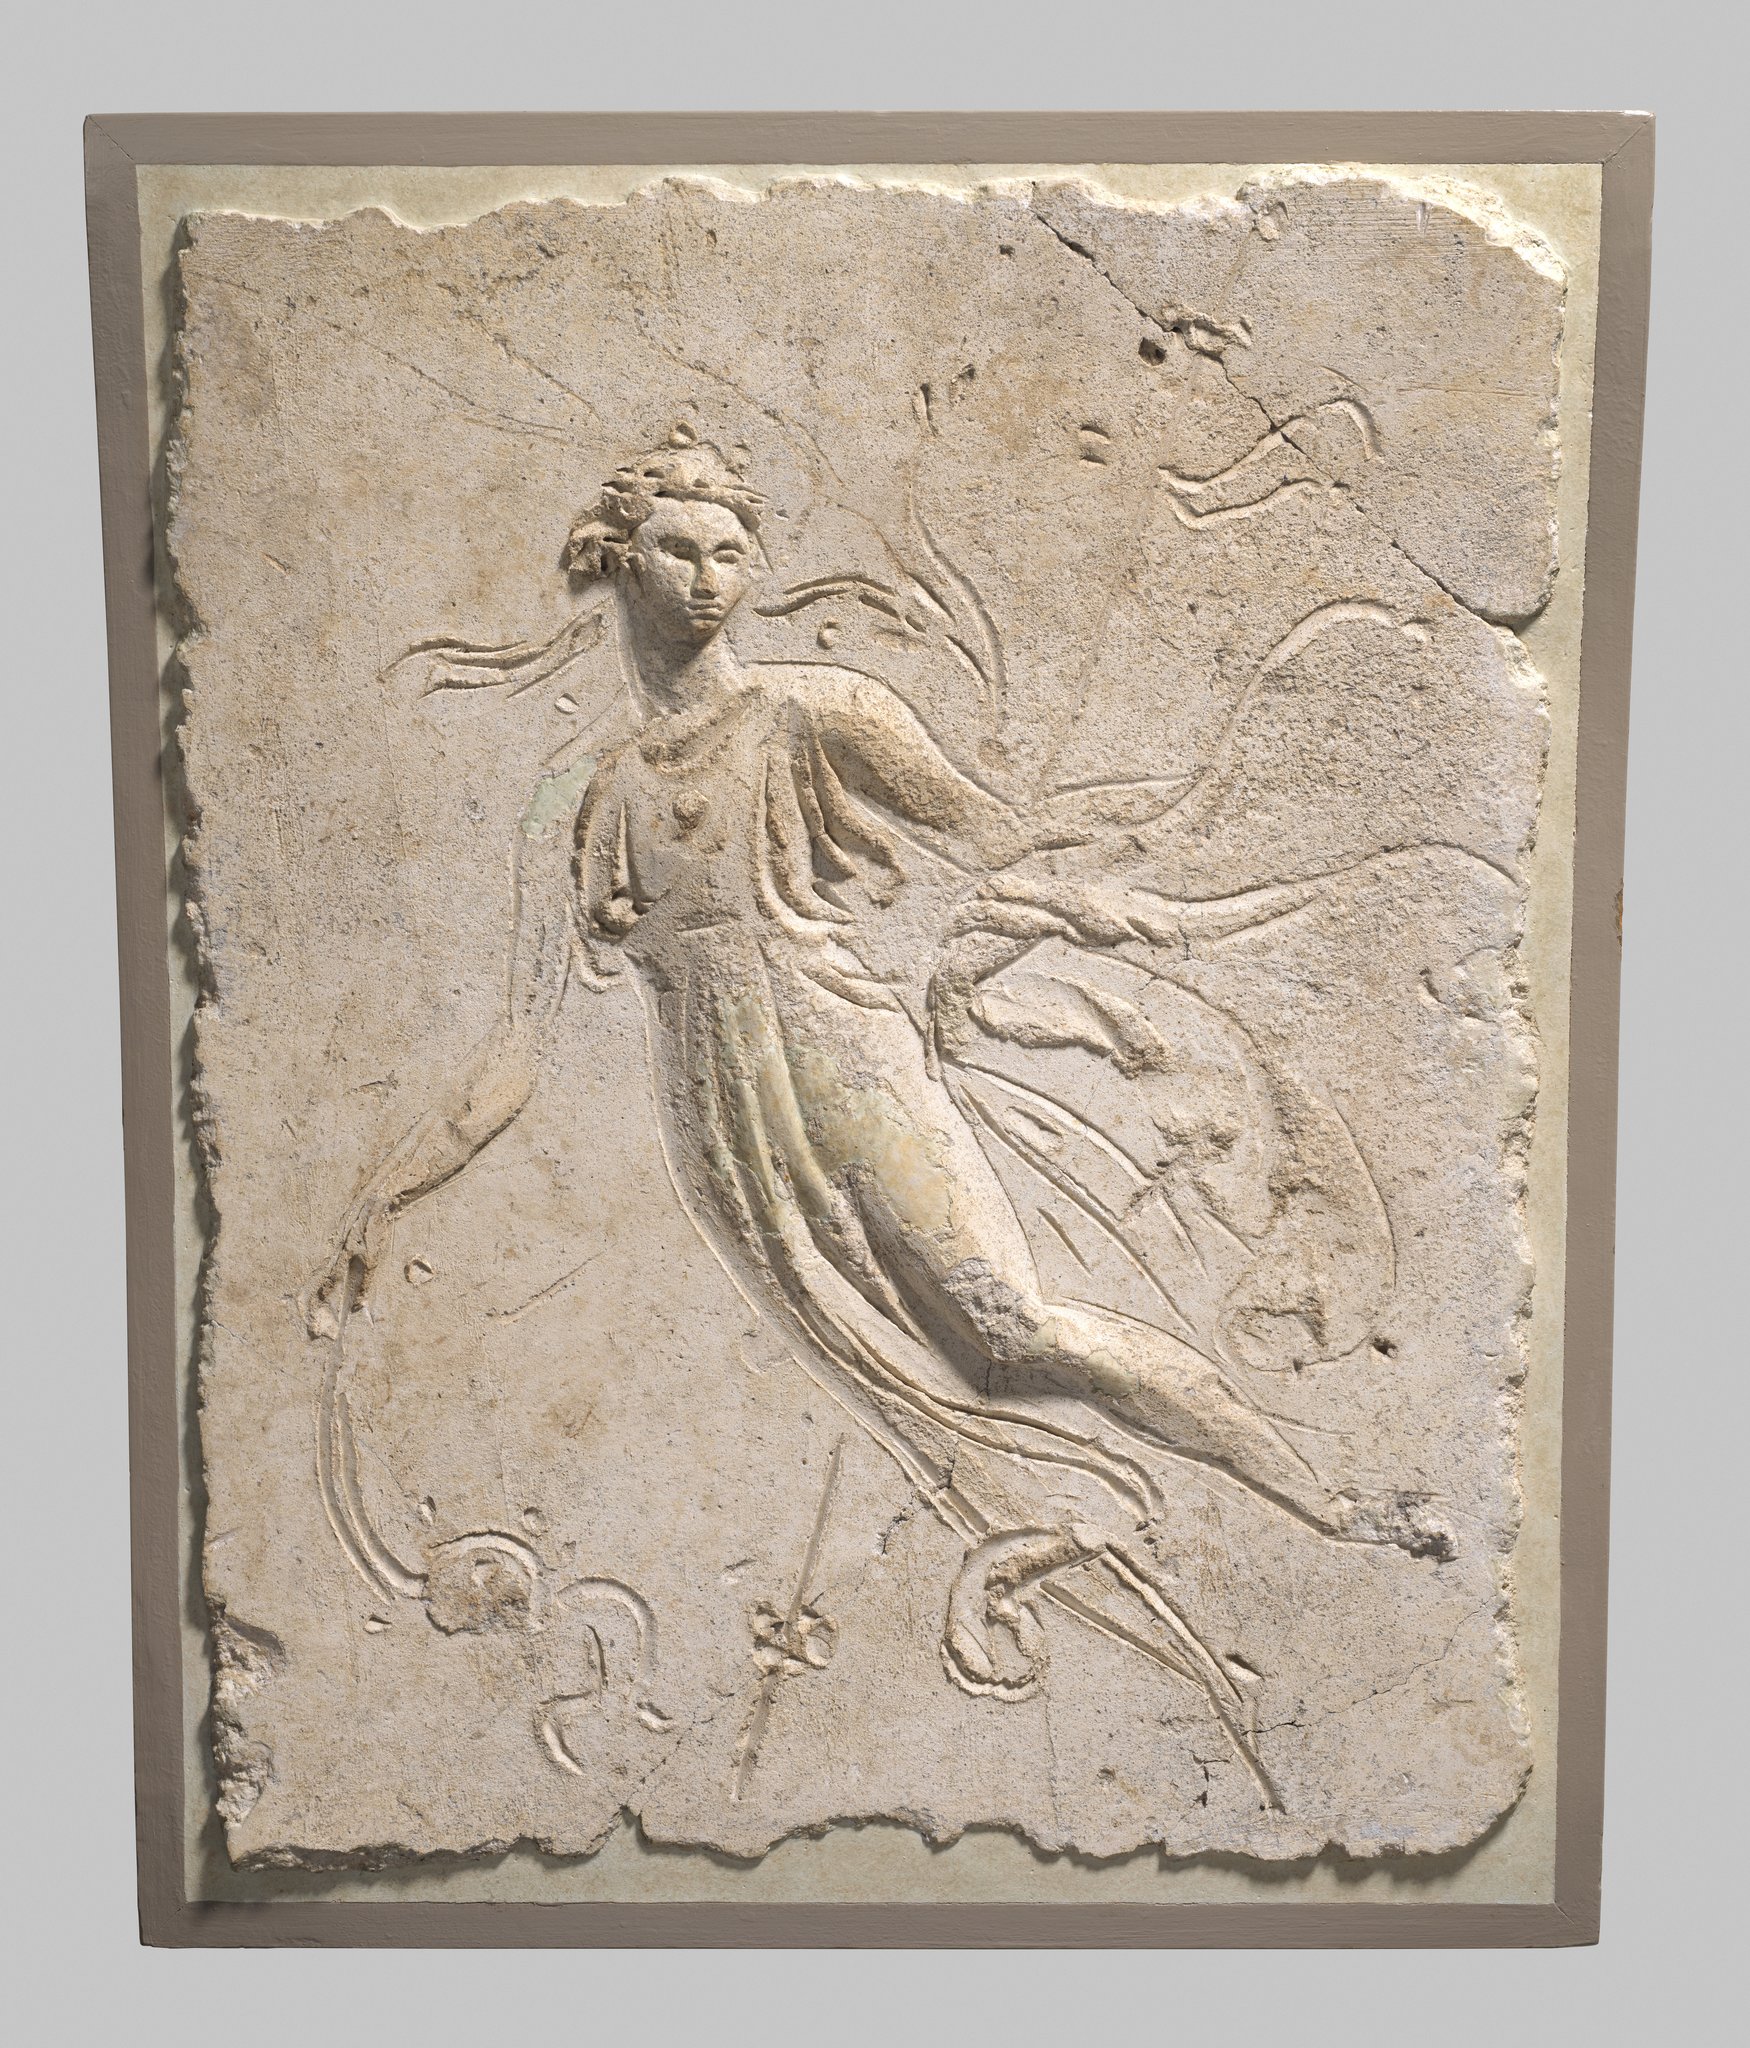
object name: stucco relief of maenad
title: Stucco relief panel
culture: roman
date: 51-100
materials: plaster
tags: women,maenads